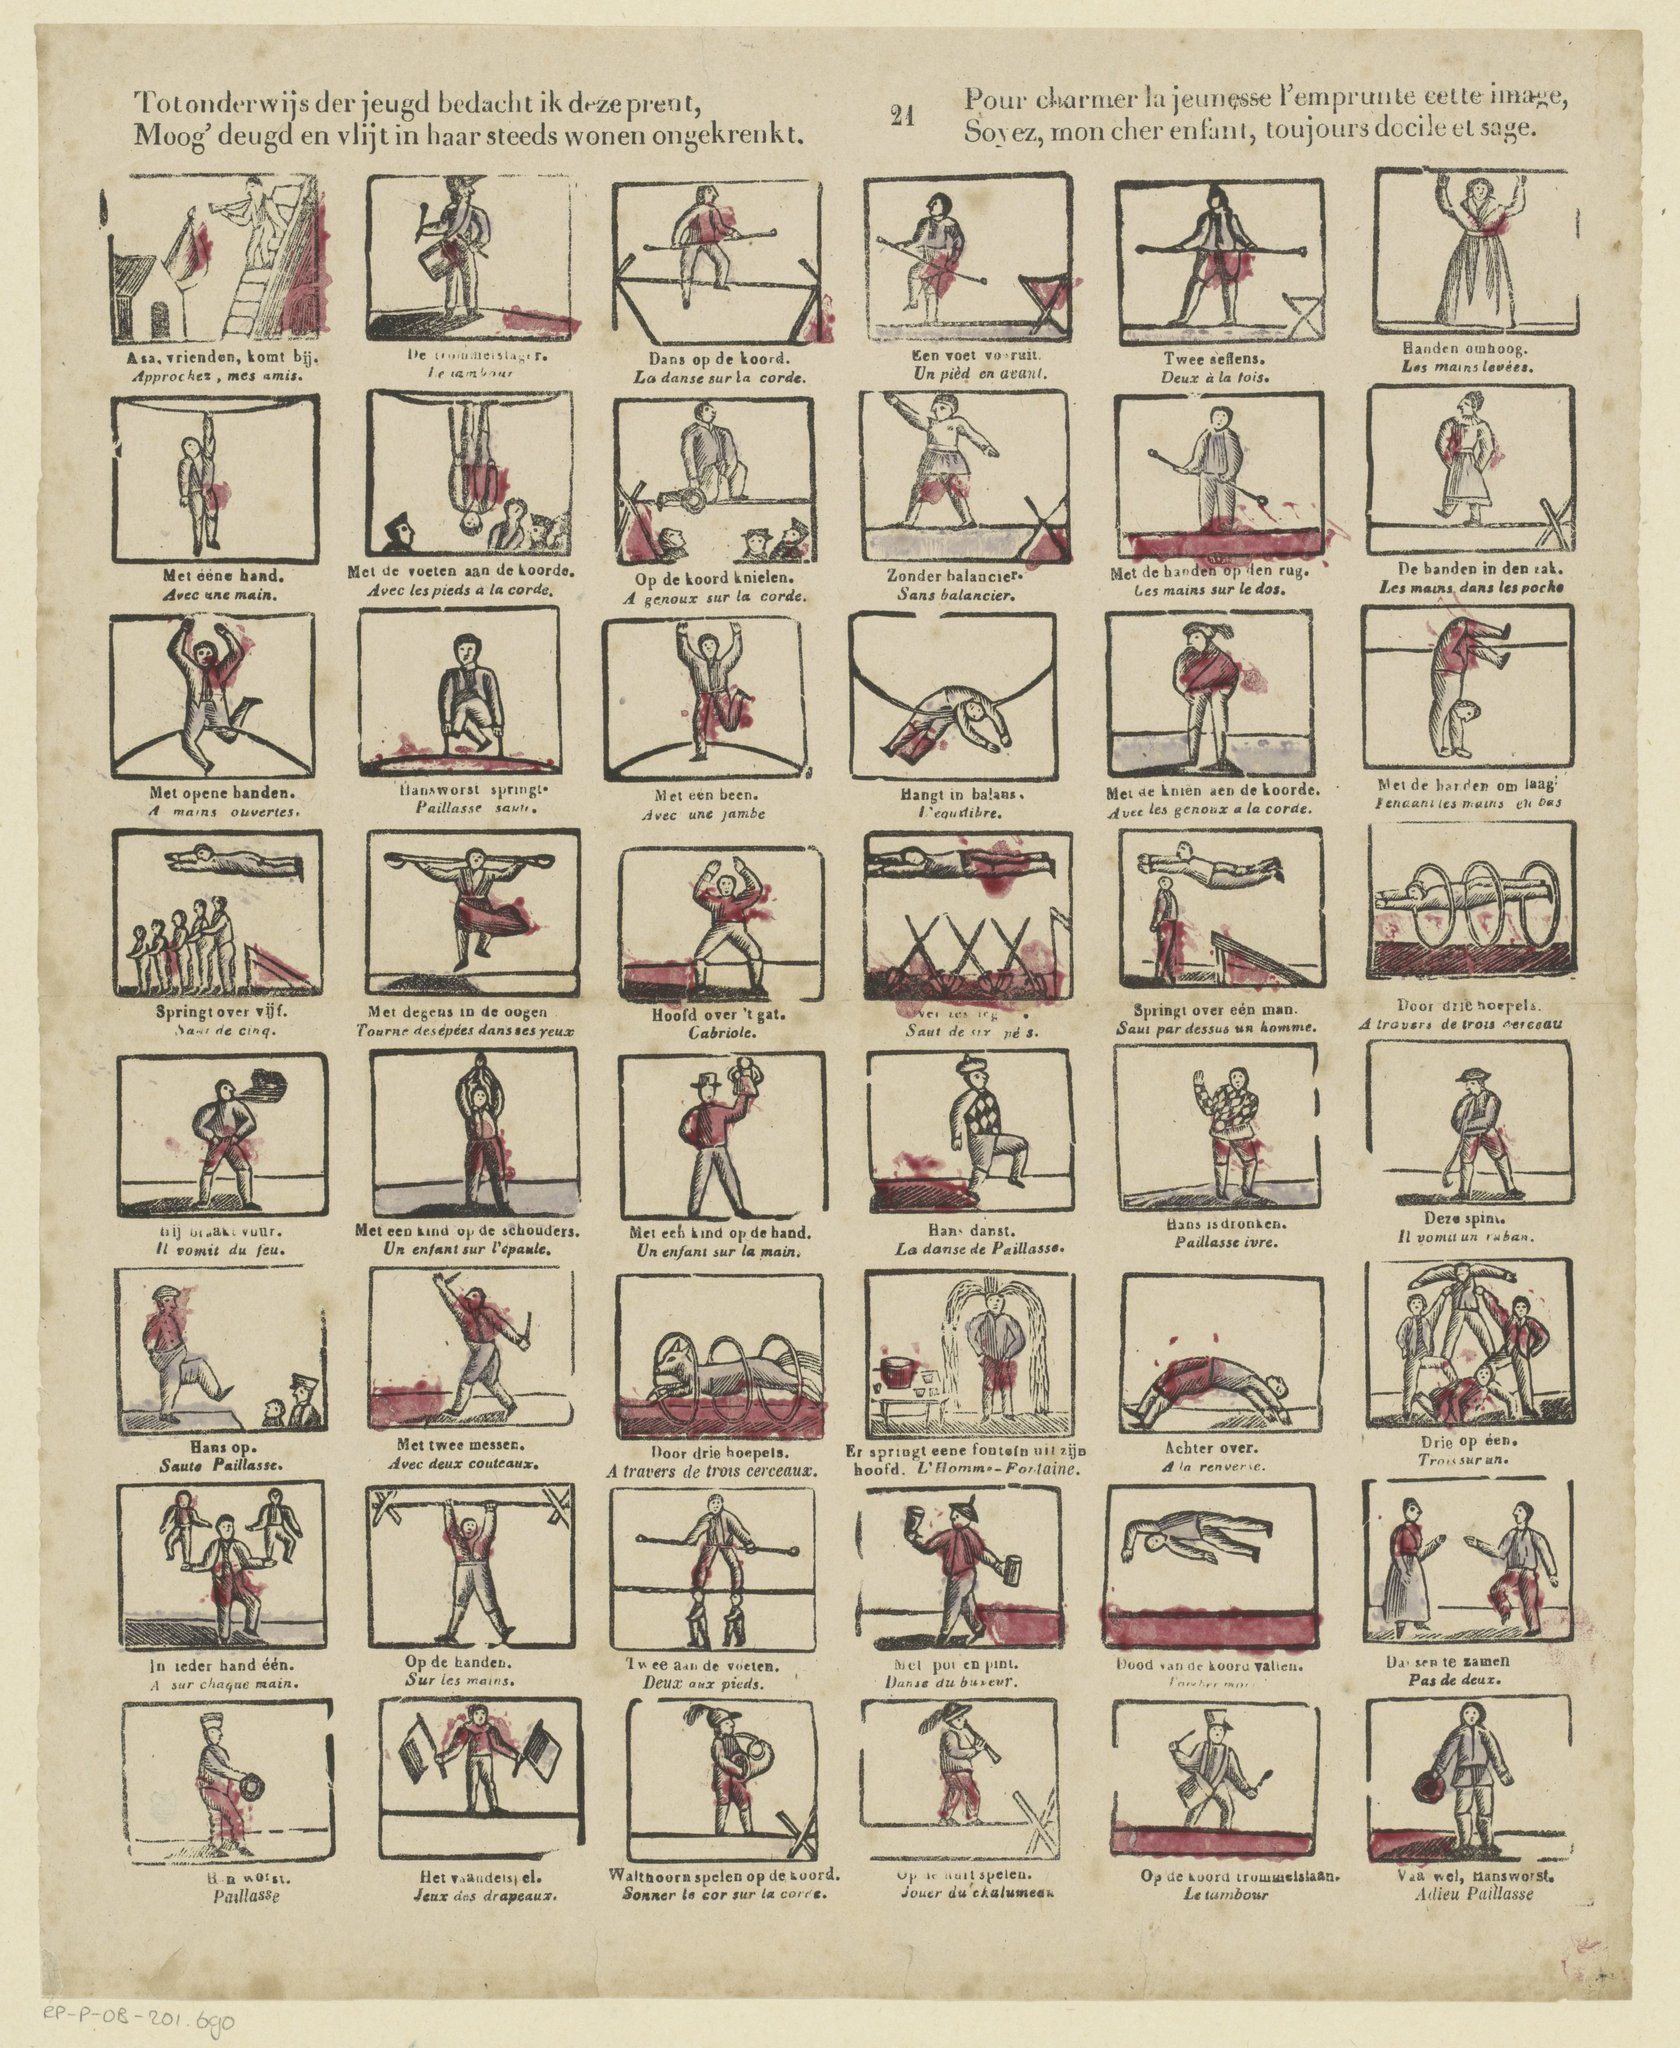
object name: popular print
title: Tot onderwijs der jeugd bedacht ik deze prent, / Moog' deugd en vlijt in haar steeds wonen ongekrenkt / Pour charmer la jeunesse j'emprunte cette image, / Soyez, mon cher enfant, toujours docile et sage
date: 1800-1833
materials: paper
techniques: colour, letterpress printing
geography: turnhout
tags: equilibrist, dancing, acrobat ~ circus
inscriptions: collector's mark: Lugt 2760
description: Blad met 48 voorstellingen van artiesten en kunstenmakers, waaronder koorddansers, acrobaten en dansers. Onder elke afbeelding een onderschrift in het Nederlands en in het Frans. Genummerd midden boven: 21.